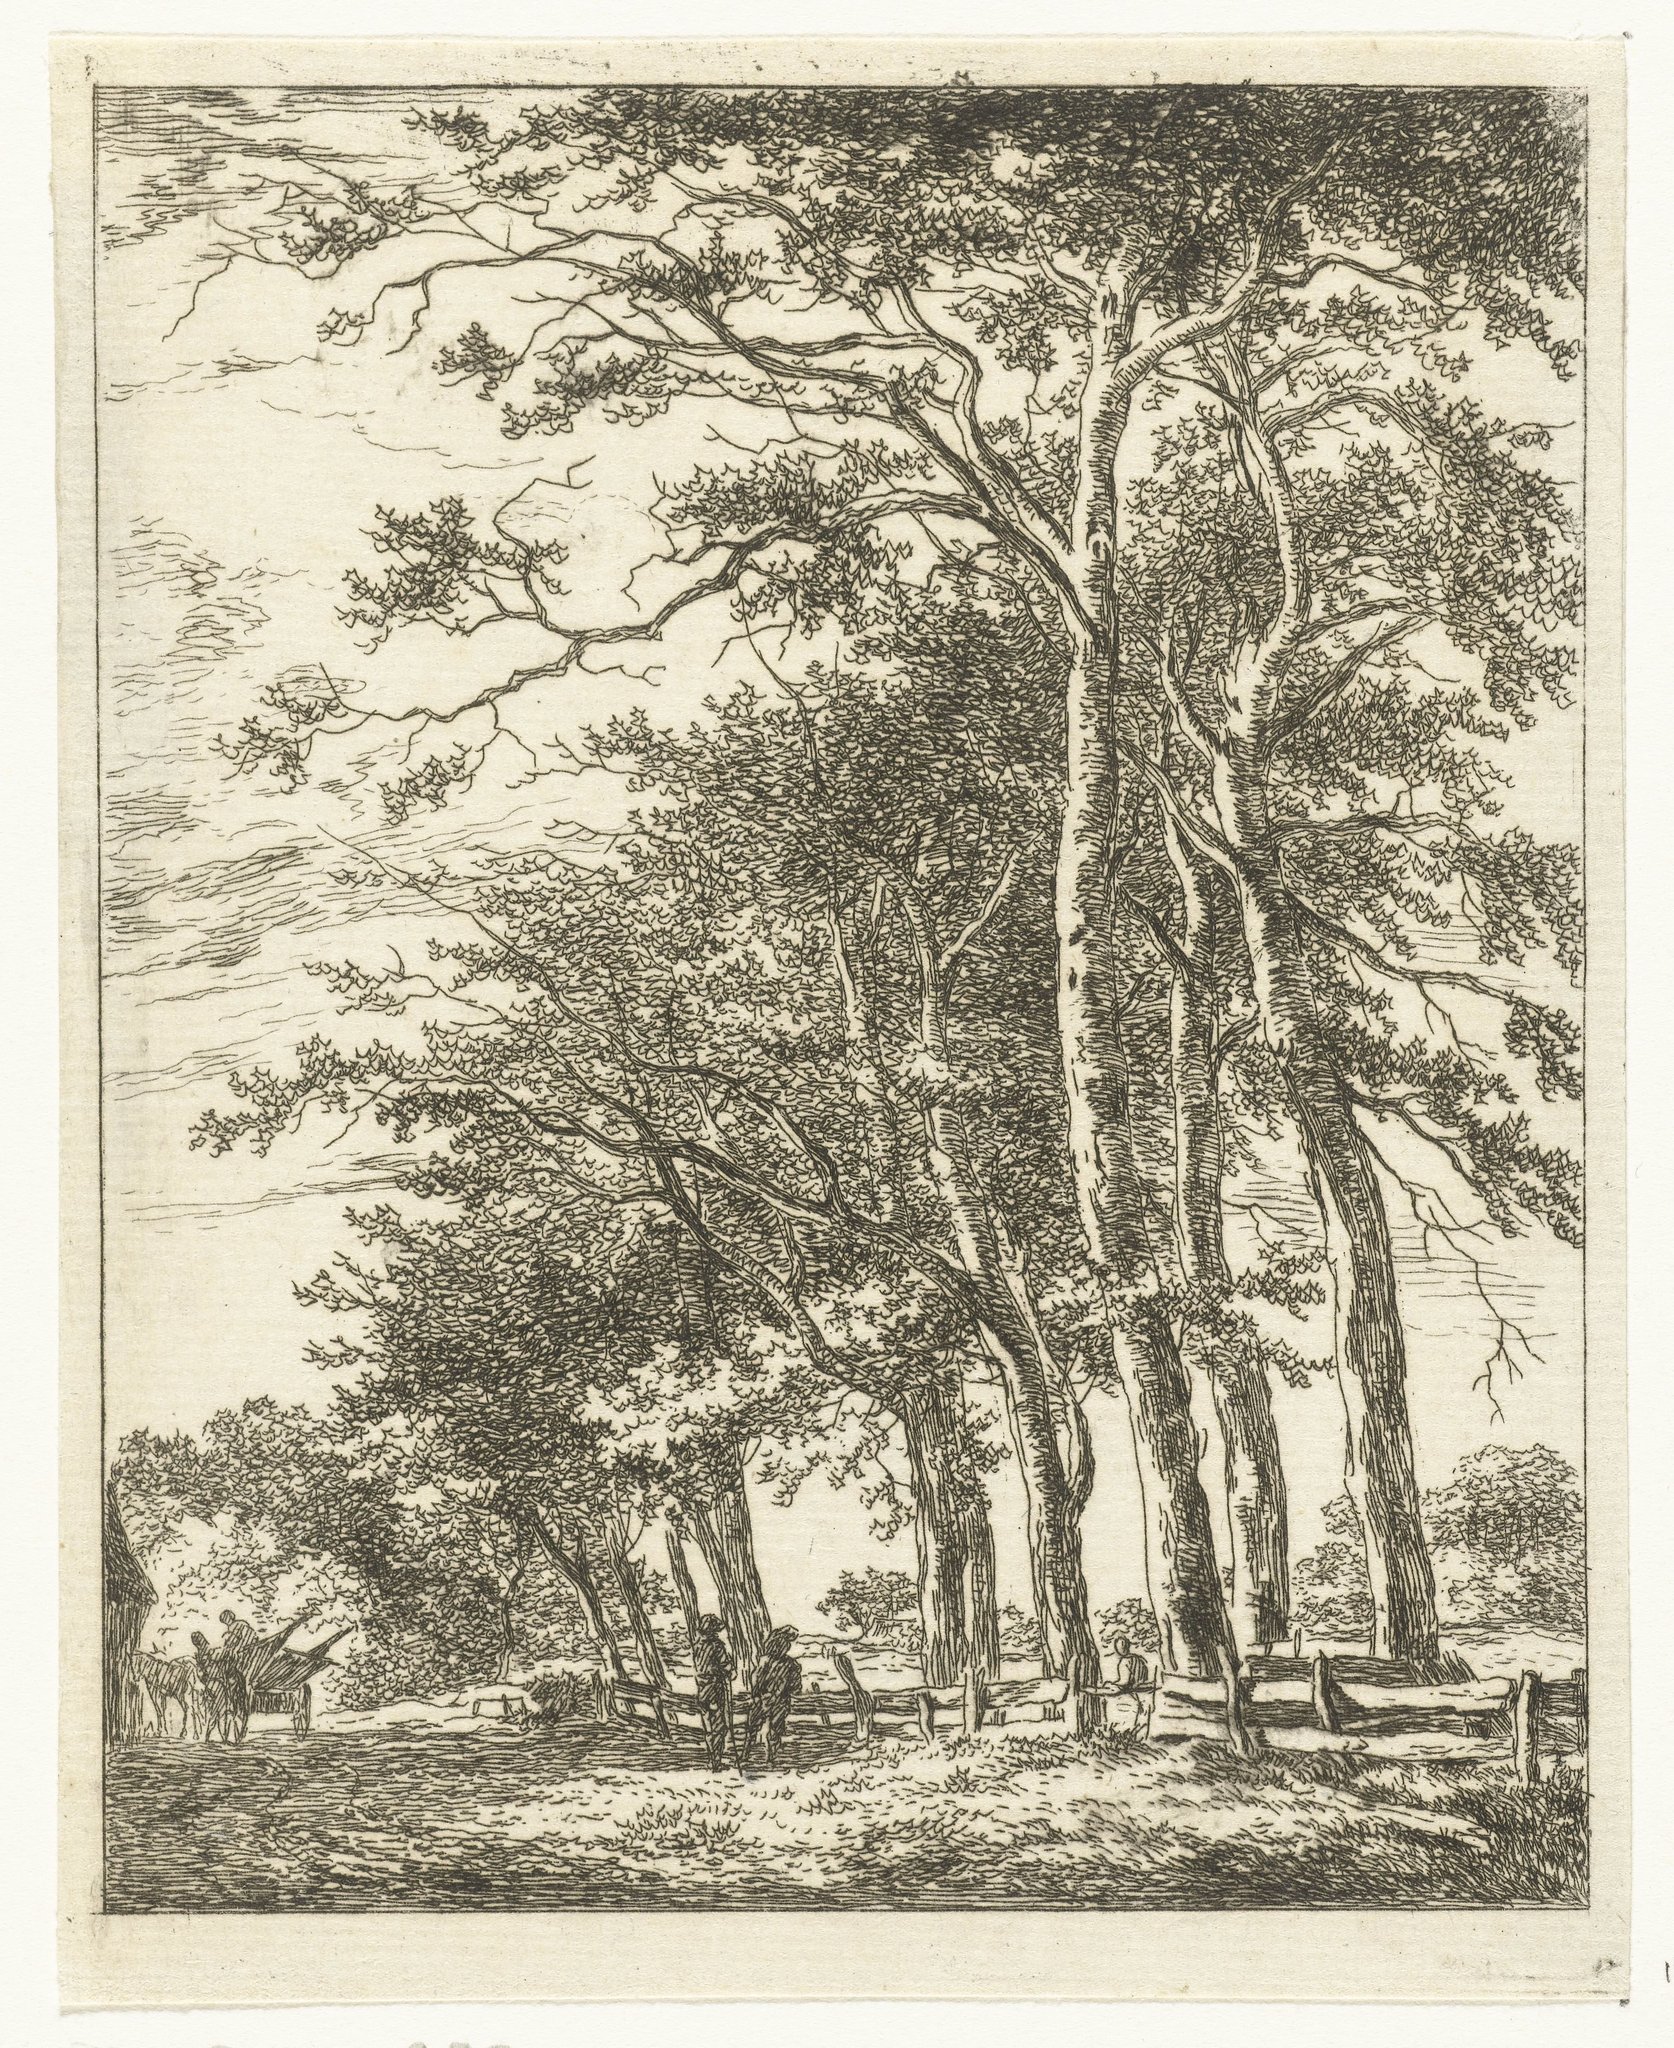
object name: print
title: Twee staande figuren bij hoge boomen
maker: hermanus van brussel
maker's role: draughtsman, print maker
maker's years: 1763-1815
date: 1800-1815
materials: paper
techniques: etching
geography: netherlands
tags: forest, wood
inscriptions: collector's mark: Lugt 2228